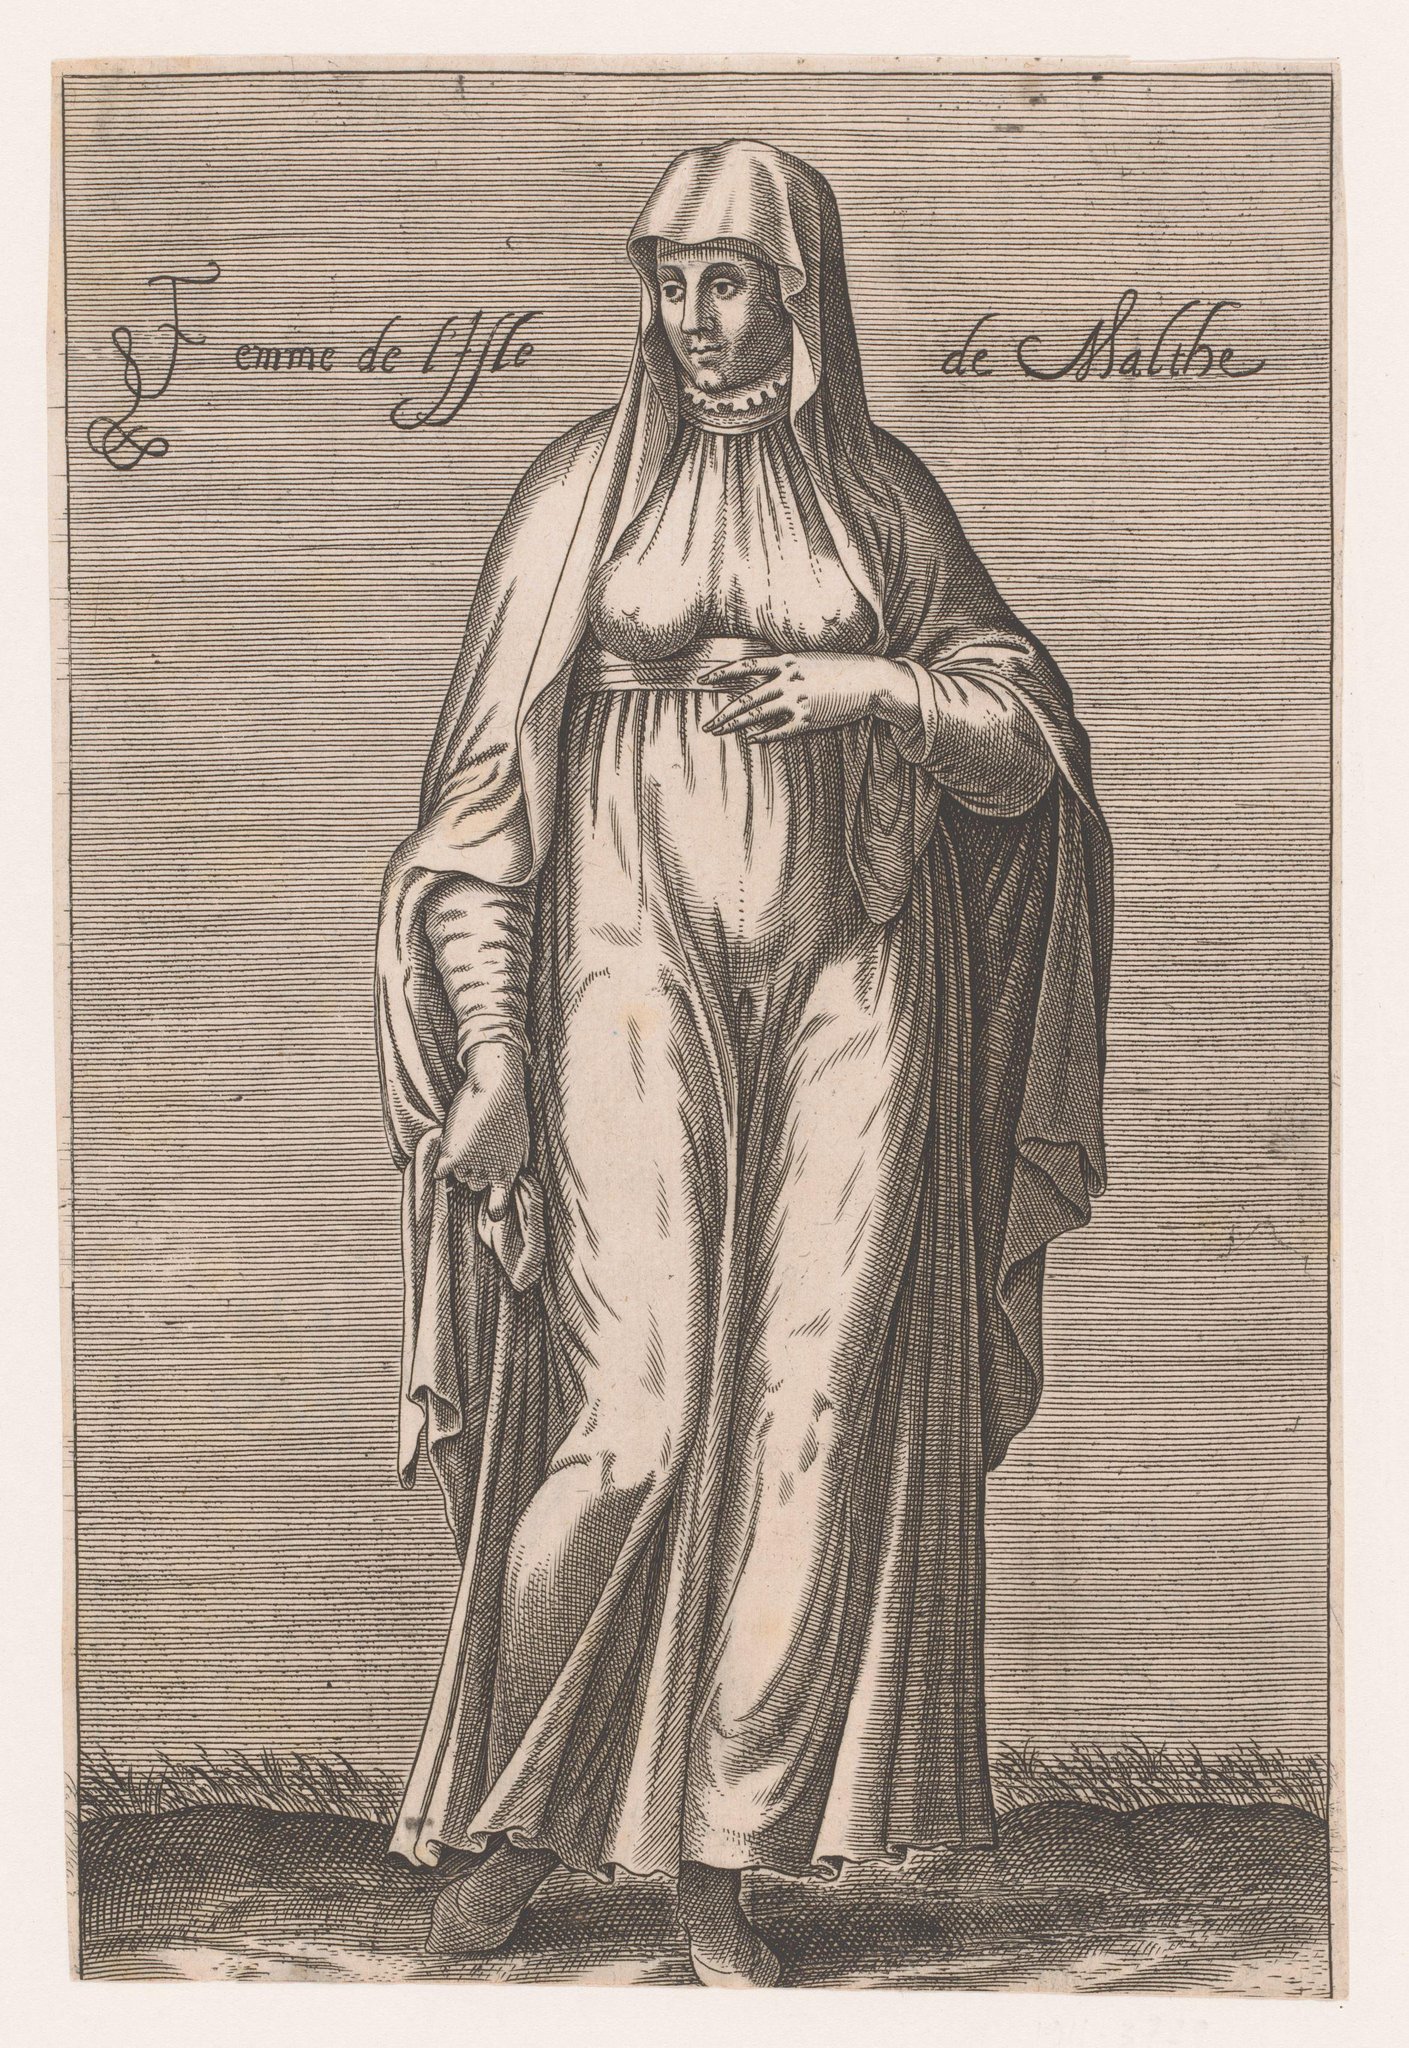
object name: print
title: Femme de l'Isle de Malthe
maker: Anonymous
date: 1567-1600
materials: paper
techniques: engraving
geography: france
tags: adult woman, folk costume, regional costume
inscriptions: collector's mark: Lugt 2228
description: Naar een prent door Léon Davent uit: Nicolay, Nicolas de & Ronsard, Pierre de. Les quatre premiers livres des navigations et pérégrinations orientales (...). Lyon: Guillaume (I) Rouille, 1567.